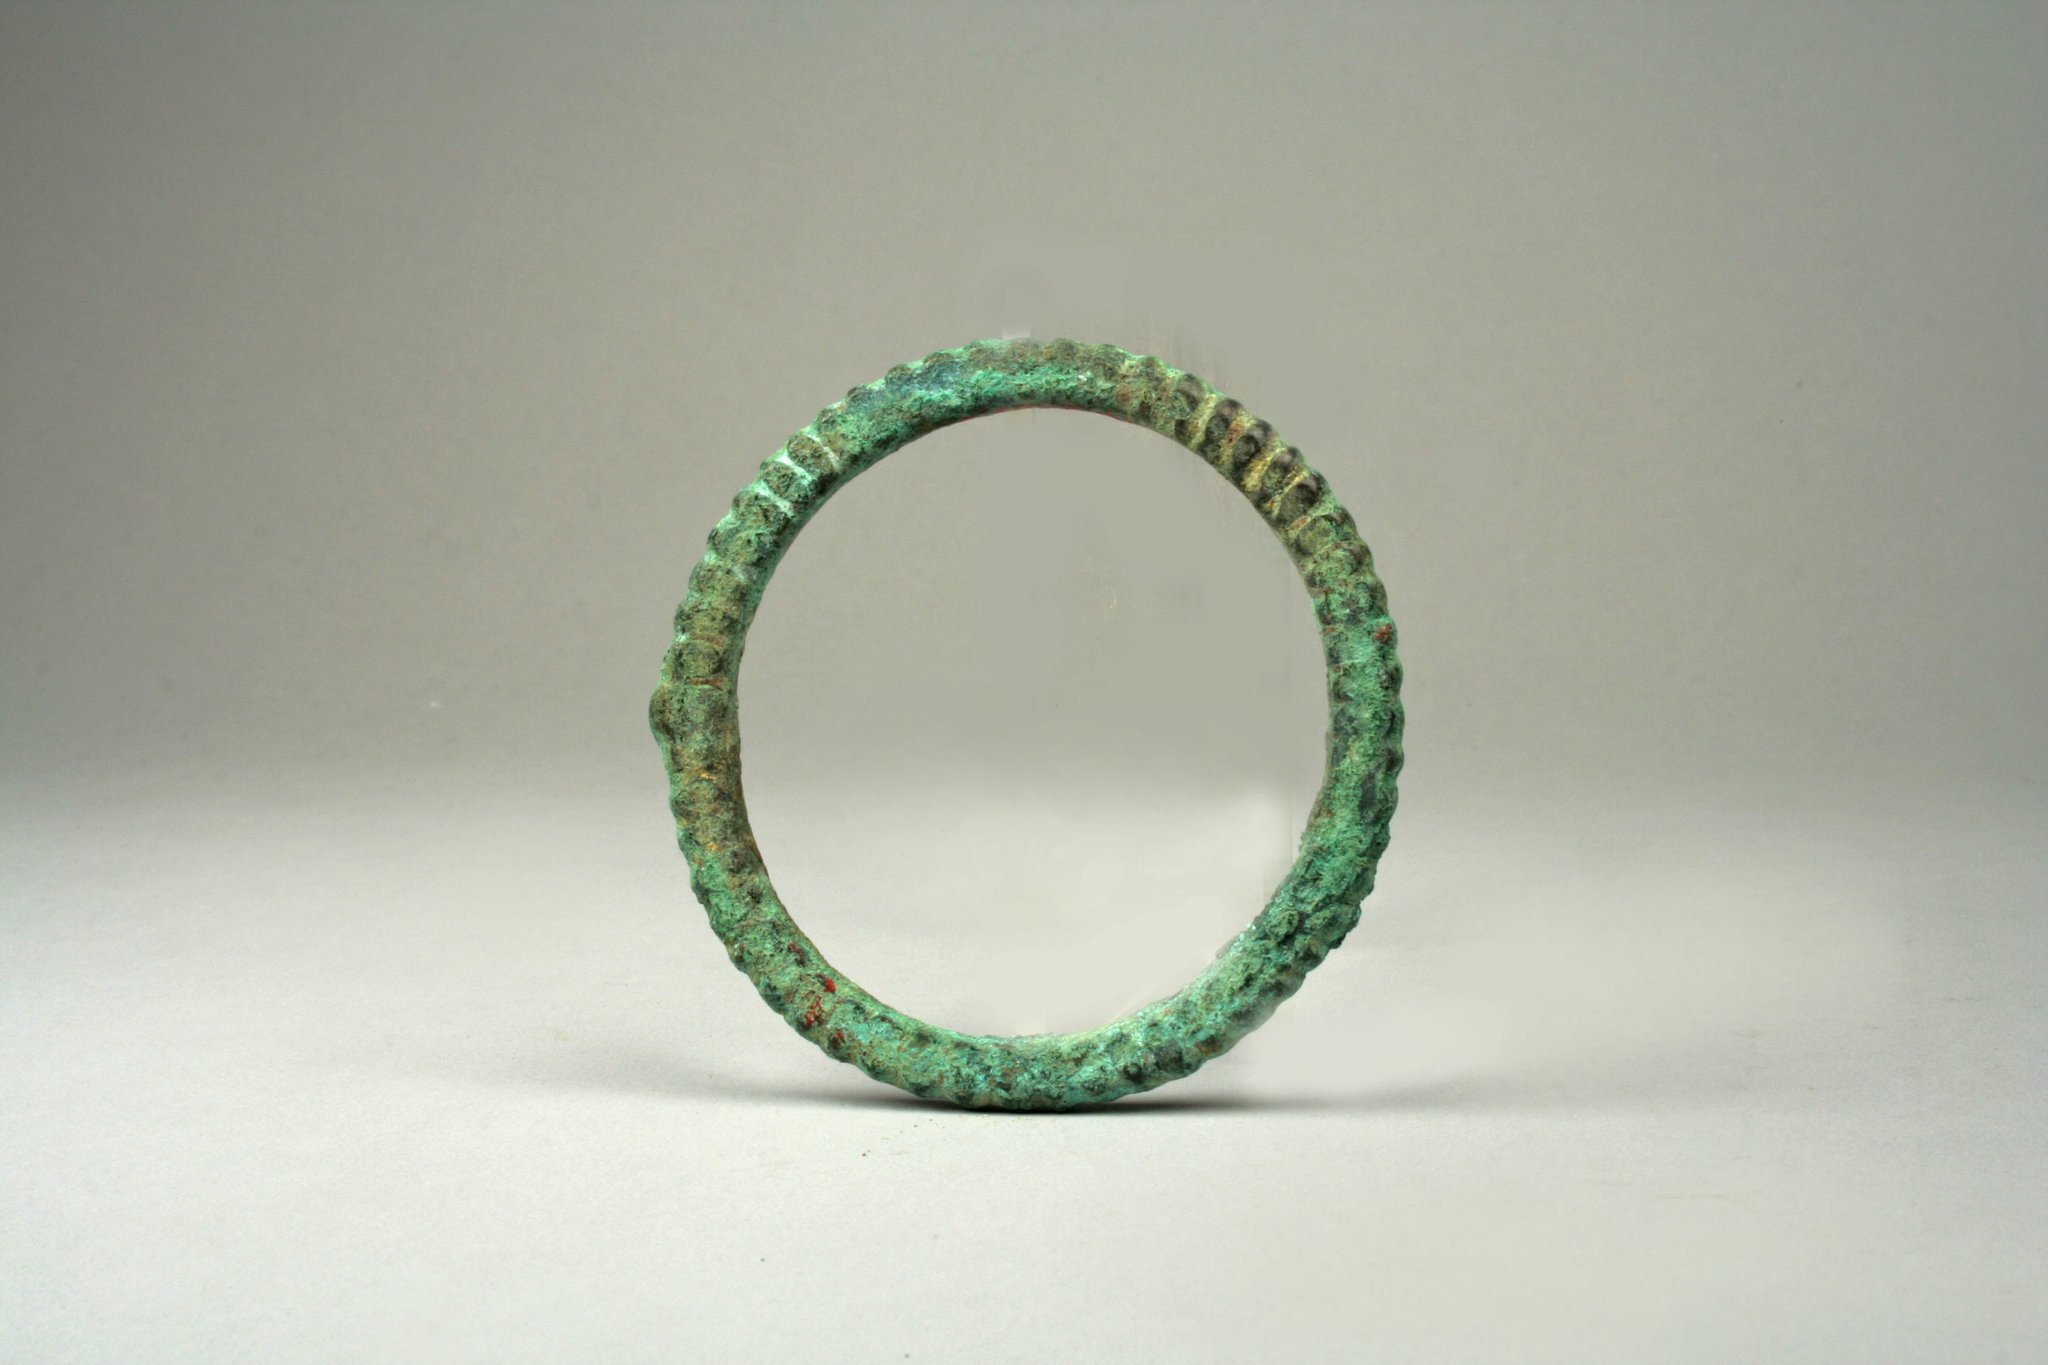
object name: bracelet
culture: middle niger civilization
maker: middle niger artist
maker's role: artist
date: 1301-1400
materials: copper alloy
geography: mali